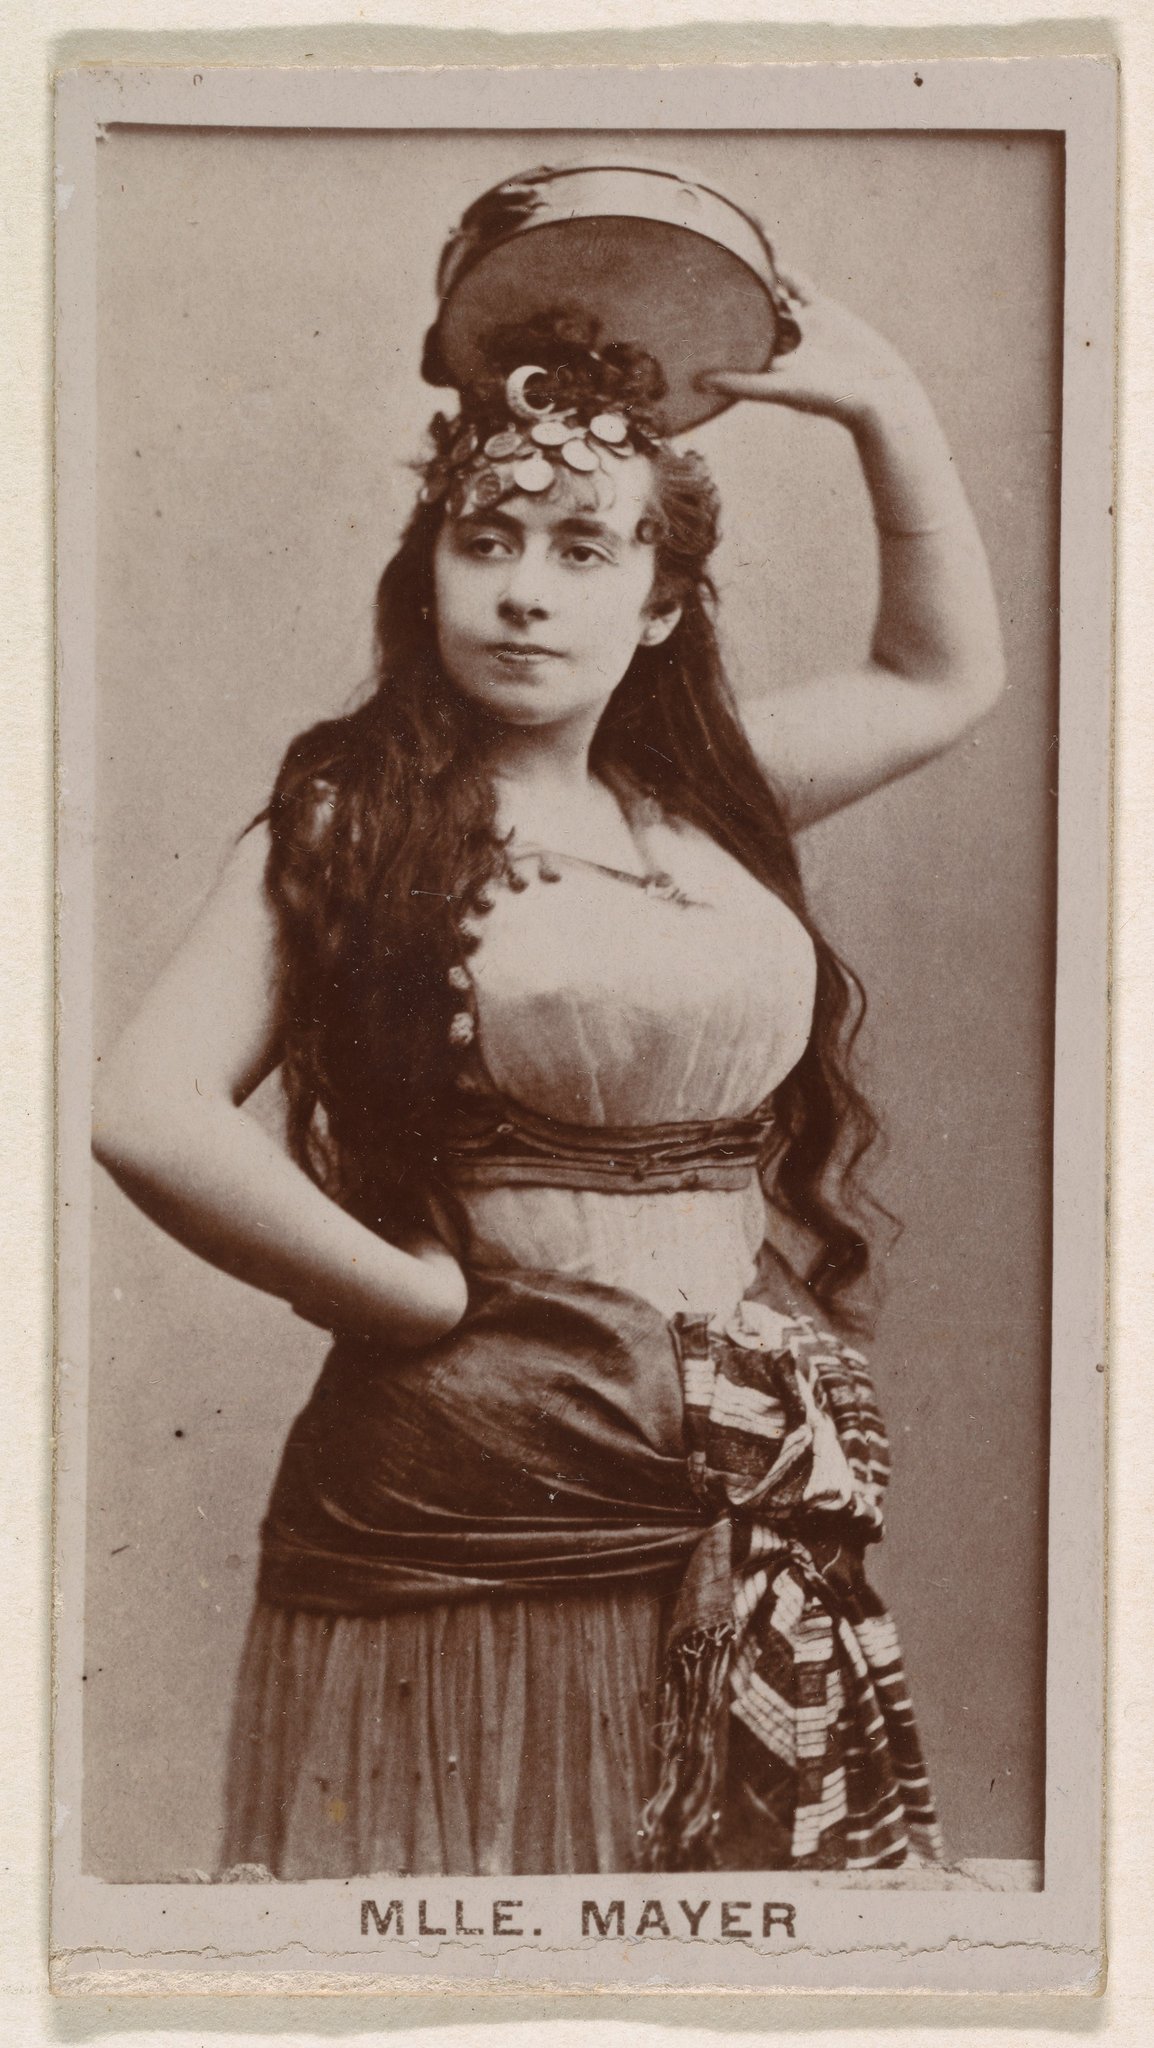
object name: photograph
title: Mlle. Mayer, from the Actresses series (N245) issued by Kinney Brothers to promote Sweet Caporal Cigarettes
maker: kinney brothers tobacco company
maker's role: publisher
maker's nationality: american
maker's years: 1869-2011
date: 1890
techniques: albumen silver print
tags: portraits,women,actresses